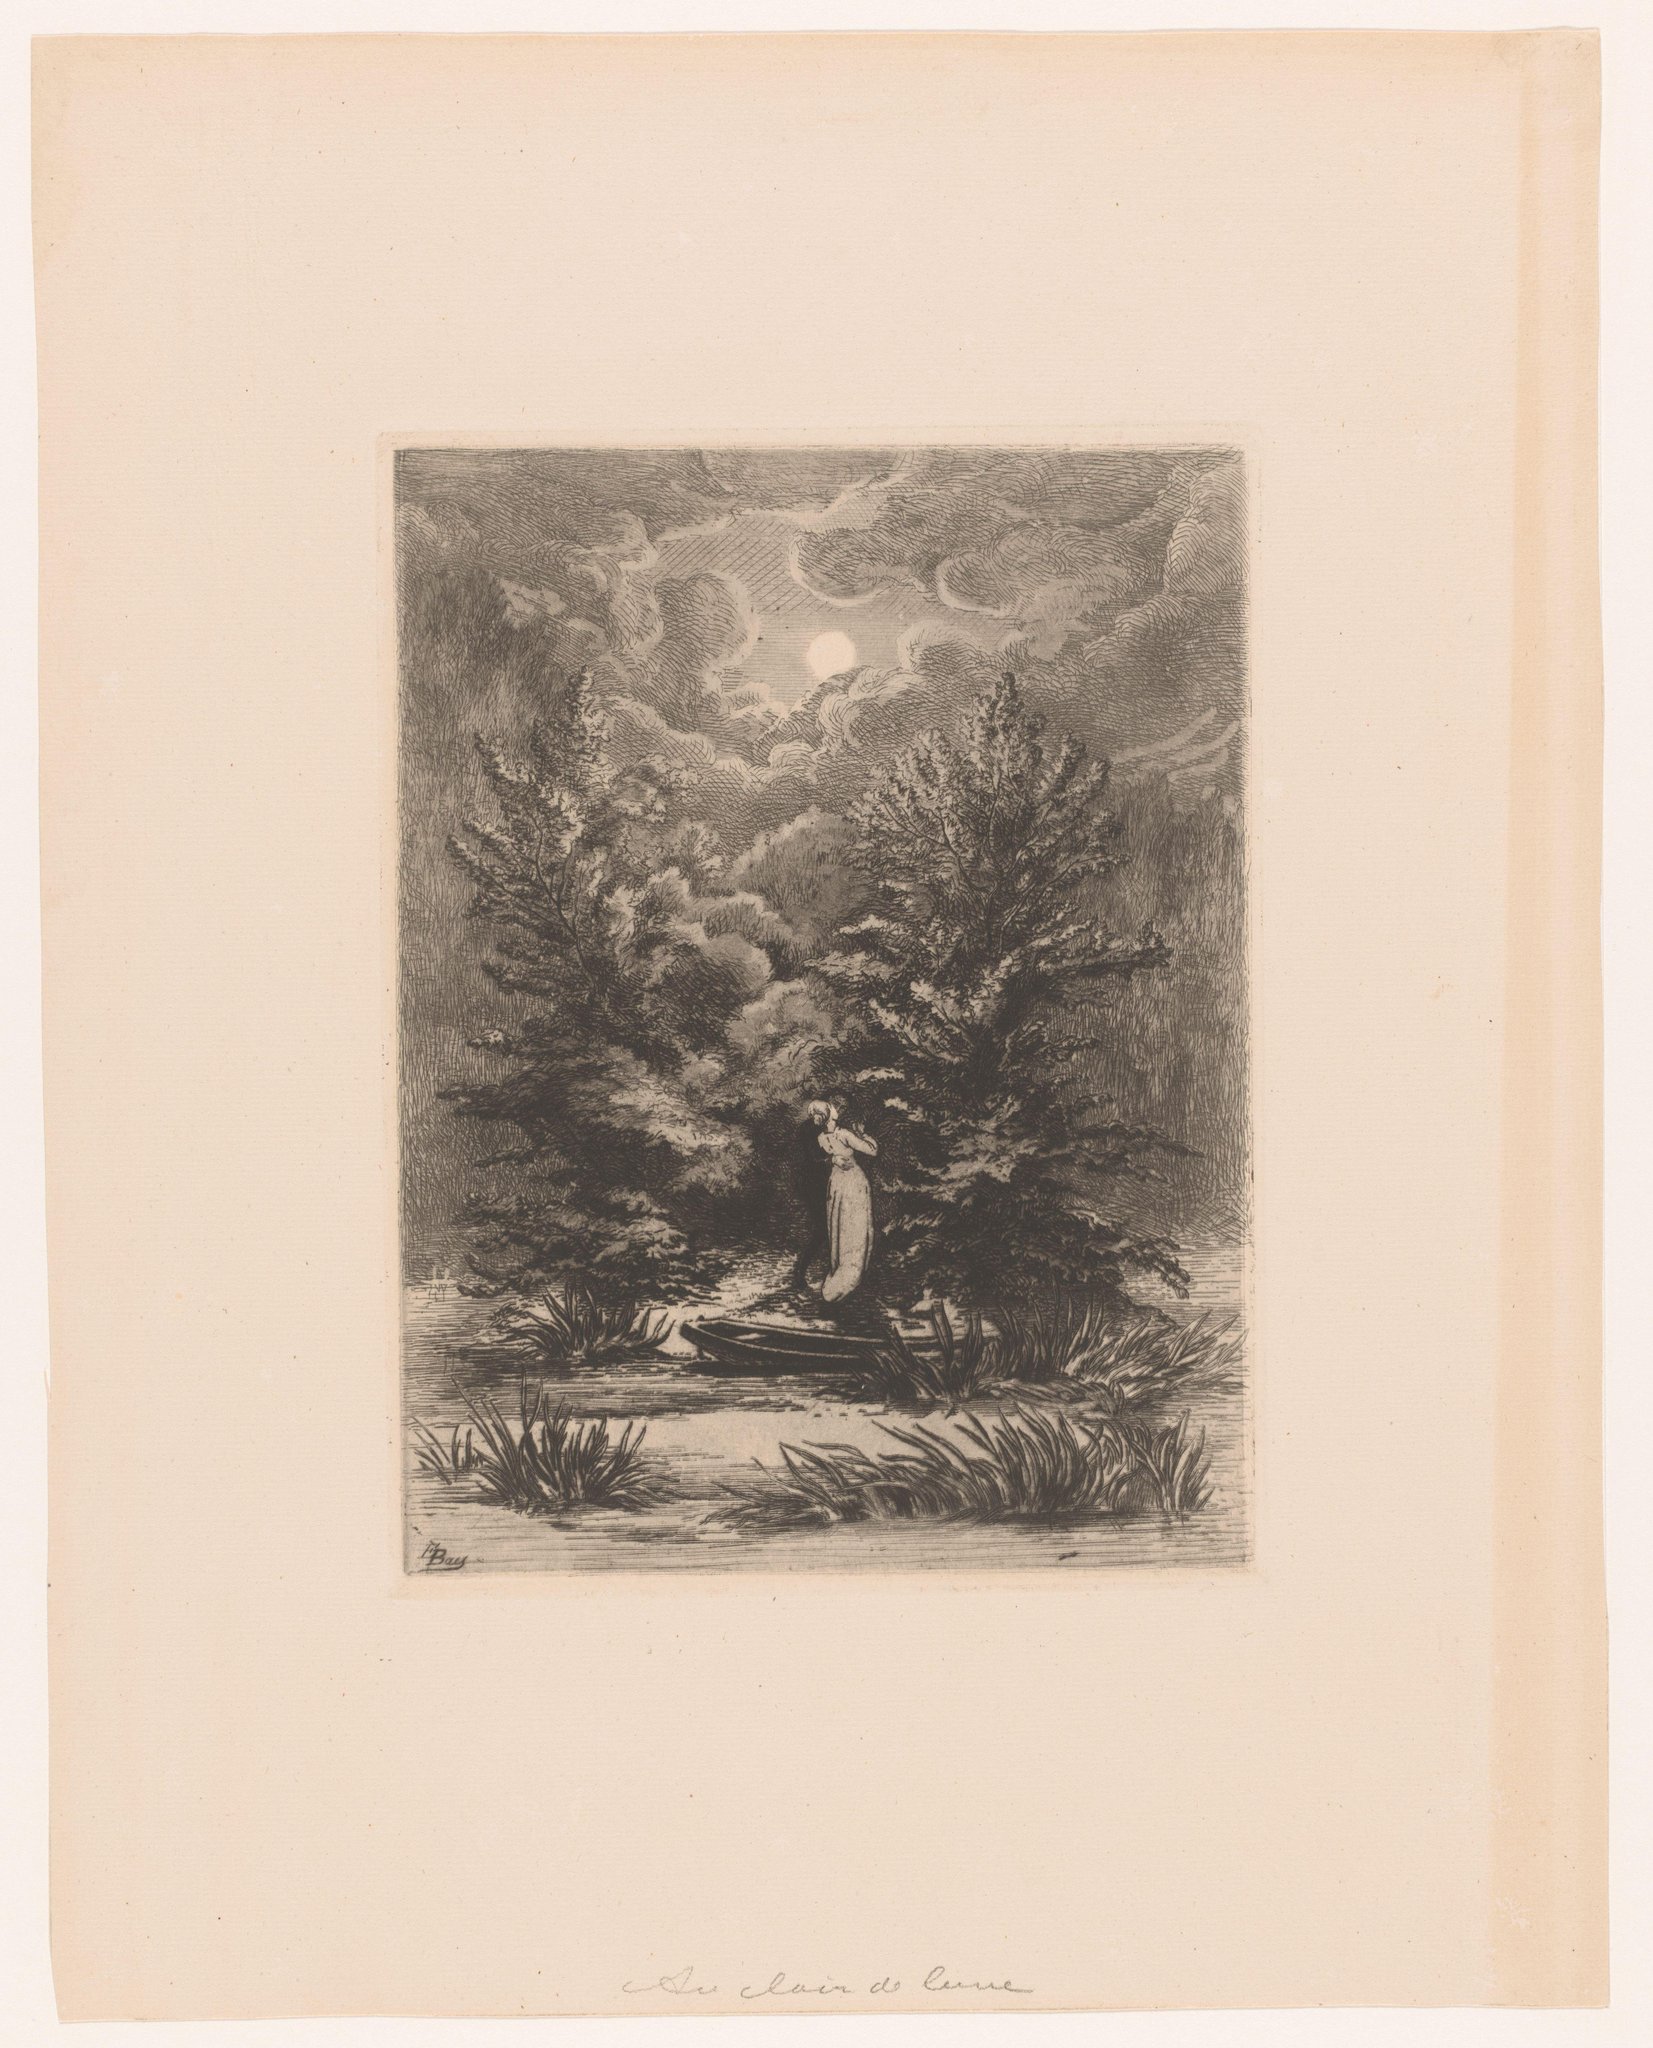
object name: print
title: Zoenend jong stel bij maanlicht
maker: edgar alfred baes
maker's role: print maker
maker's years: 1837-1909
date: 1847-1909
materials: paper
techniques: drypoint, etching, intaglio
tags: (lovers) kissing each other, moonlight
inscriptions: annotation: ‘Au clair de lune’